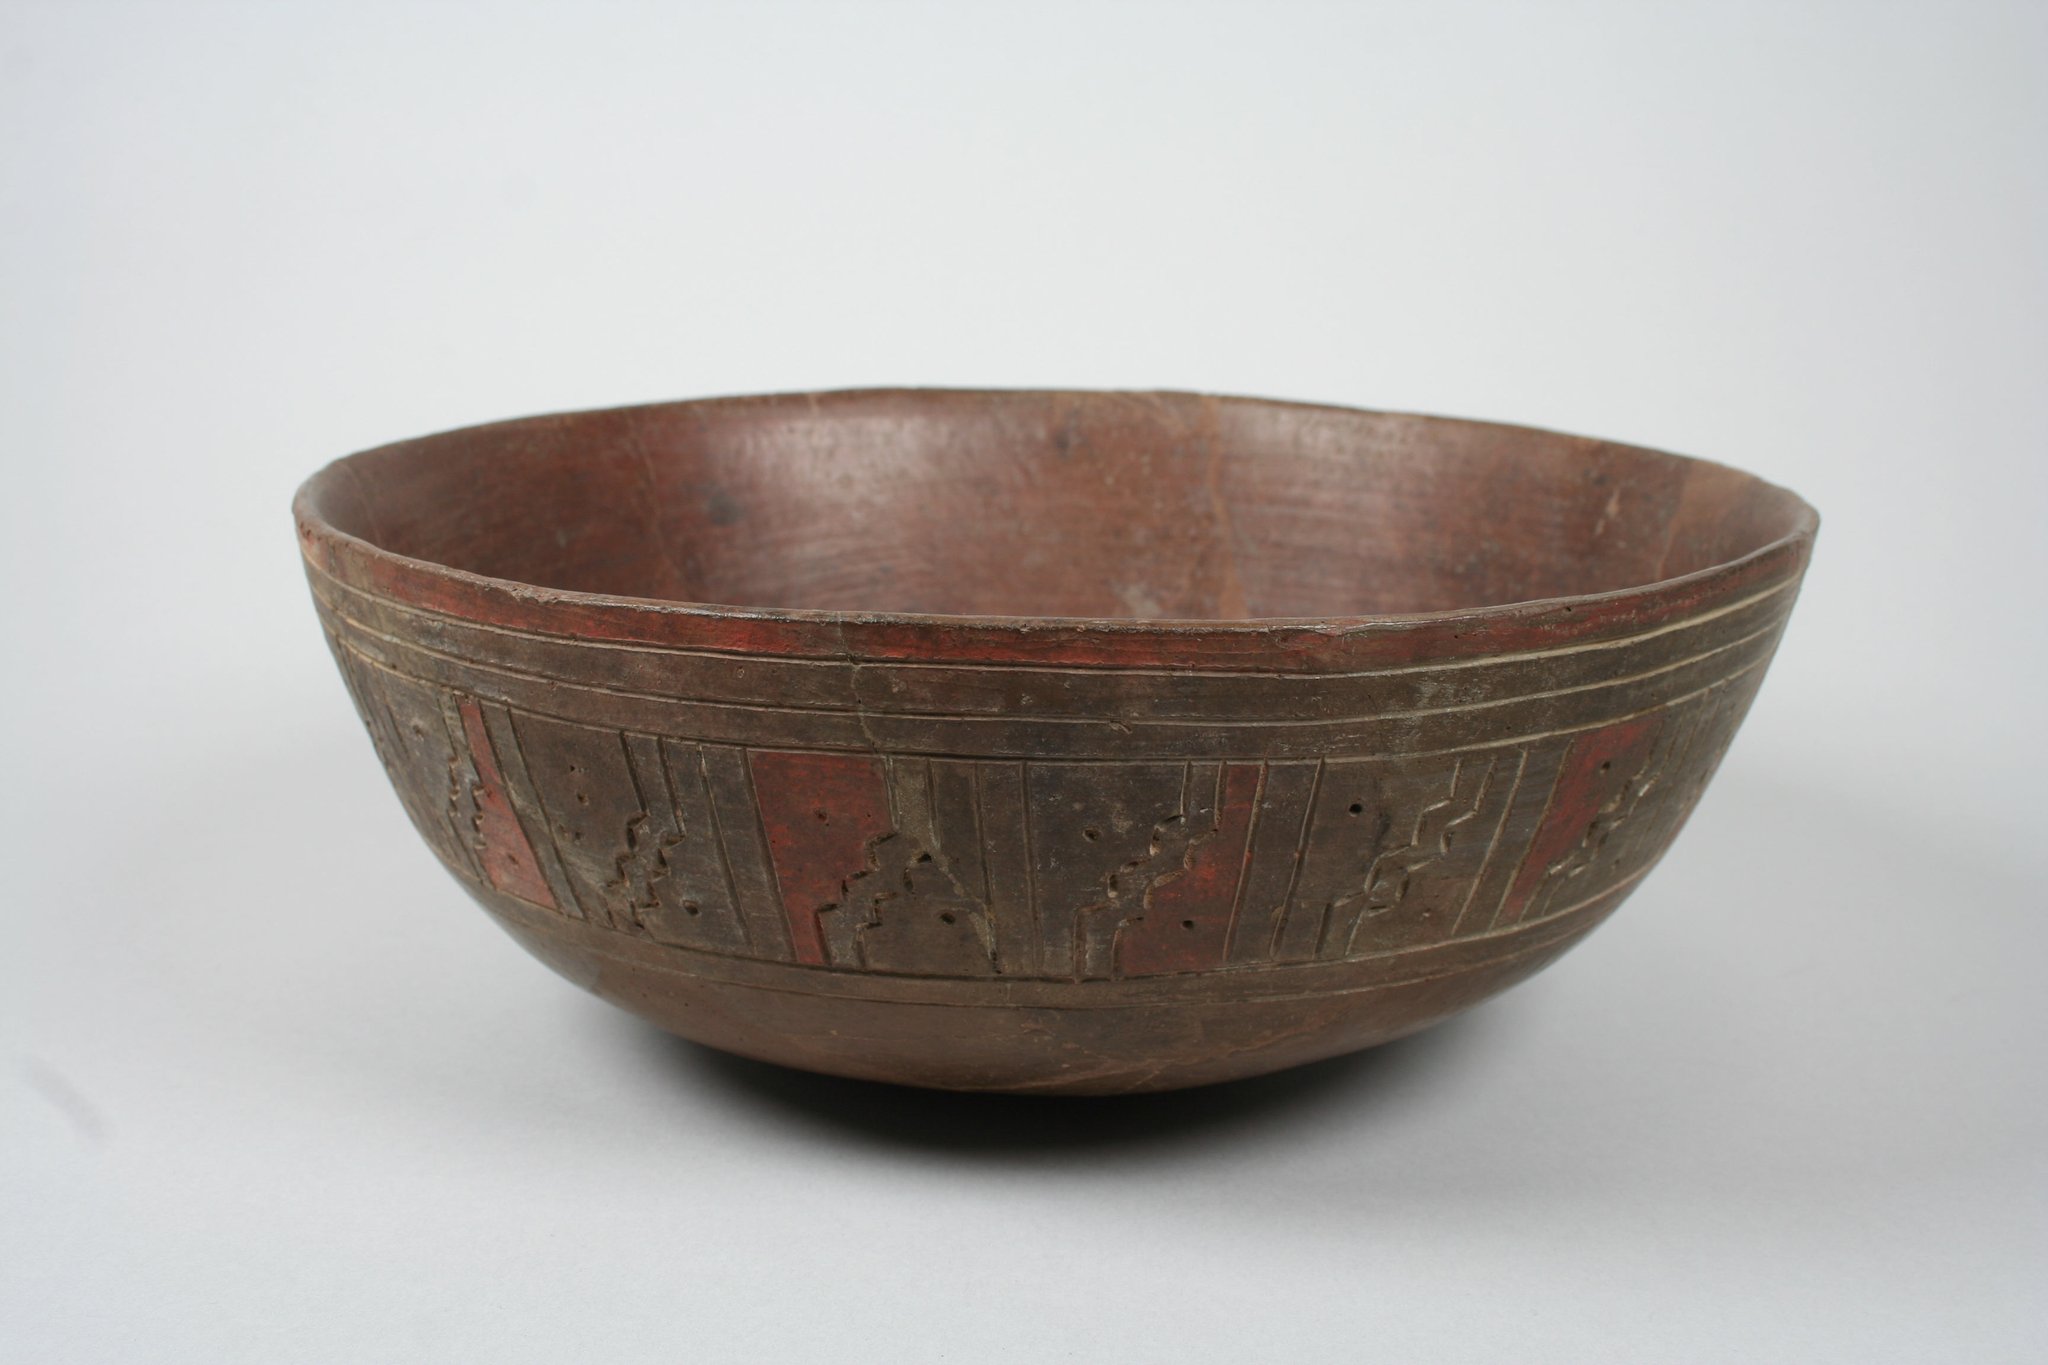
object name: bowl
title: Painted Bowl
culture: paracas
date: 600-301 BCE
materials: ceramic, pigment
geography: peru